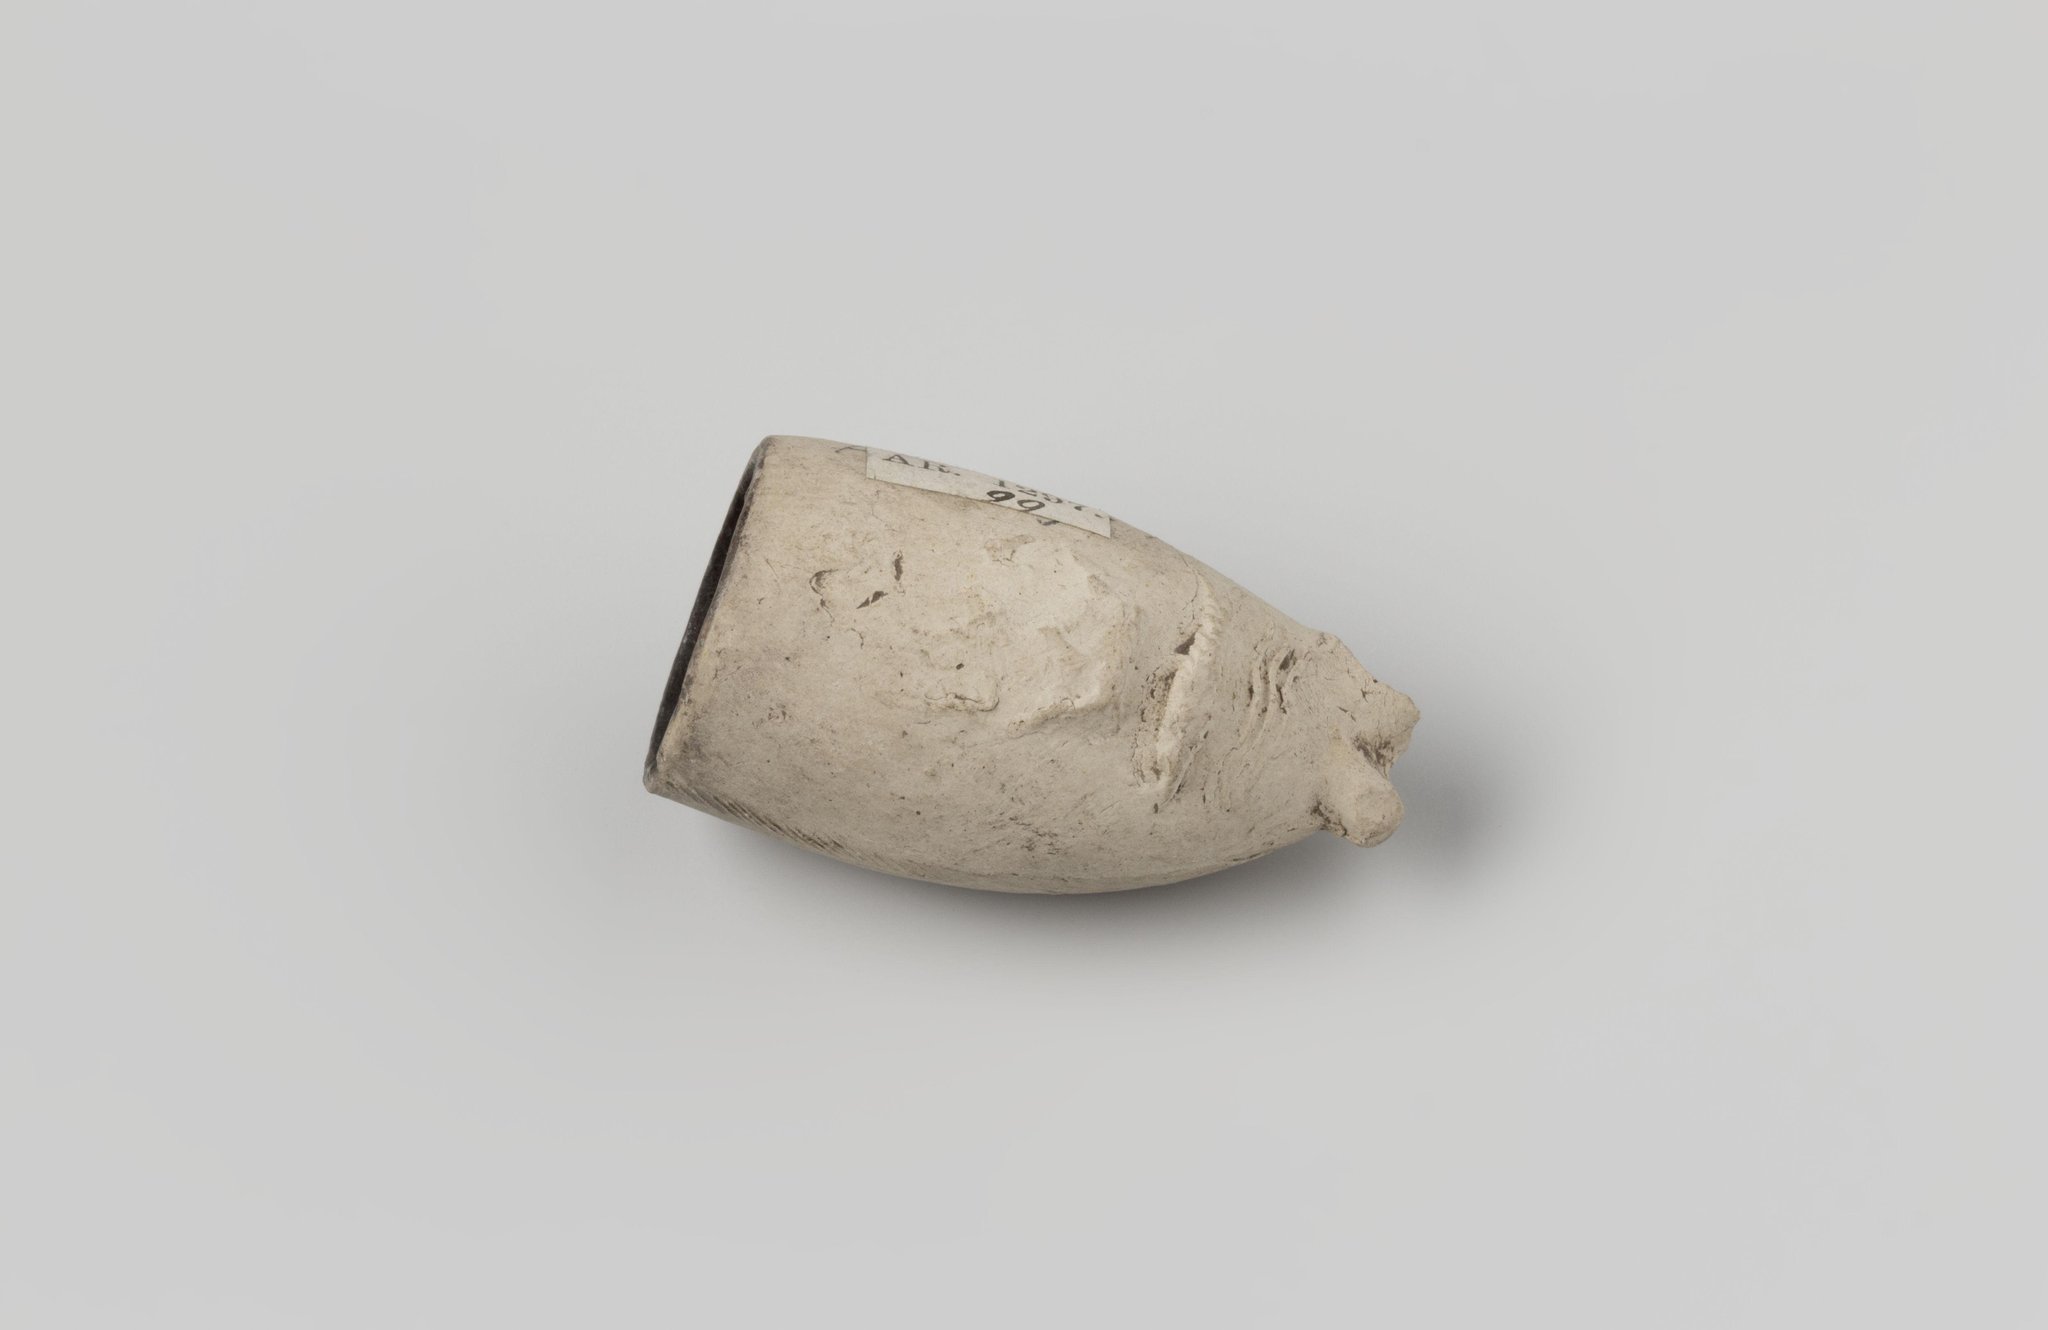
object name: fragment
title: Fragment pijpenkop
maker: jan van aten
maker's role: pijpenfabrikant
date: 1750-1780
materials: clay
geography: gorinchem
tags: directeur, hoogleraar, caspar jacob christiaan reuvens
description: Fragment pijpenkop met een kroon en een vis en drie golven, en de letters I V A afgebeeld. Van de opgravingen op de Hofstede Arentsburg 1827-1831 onder toezicht van Professor Reuvens.